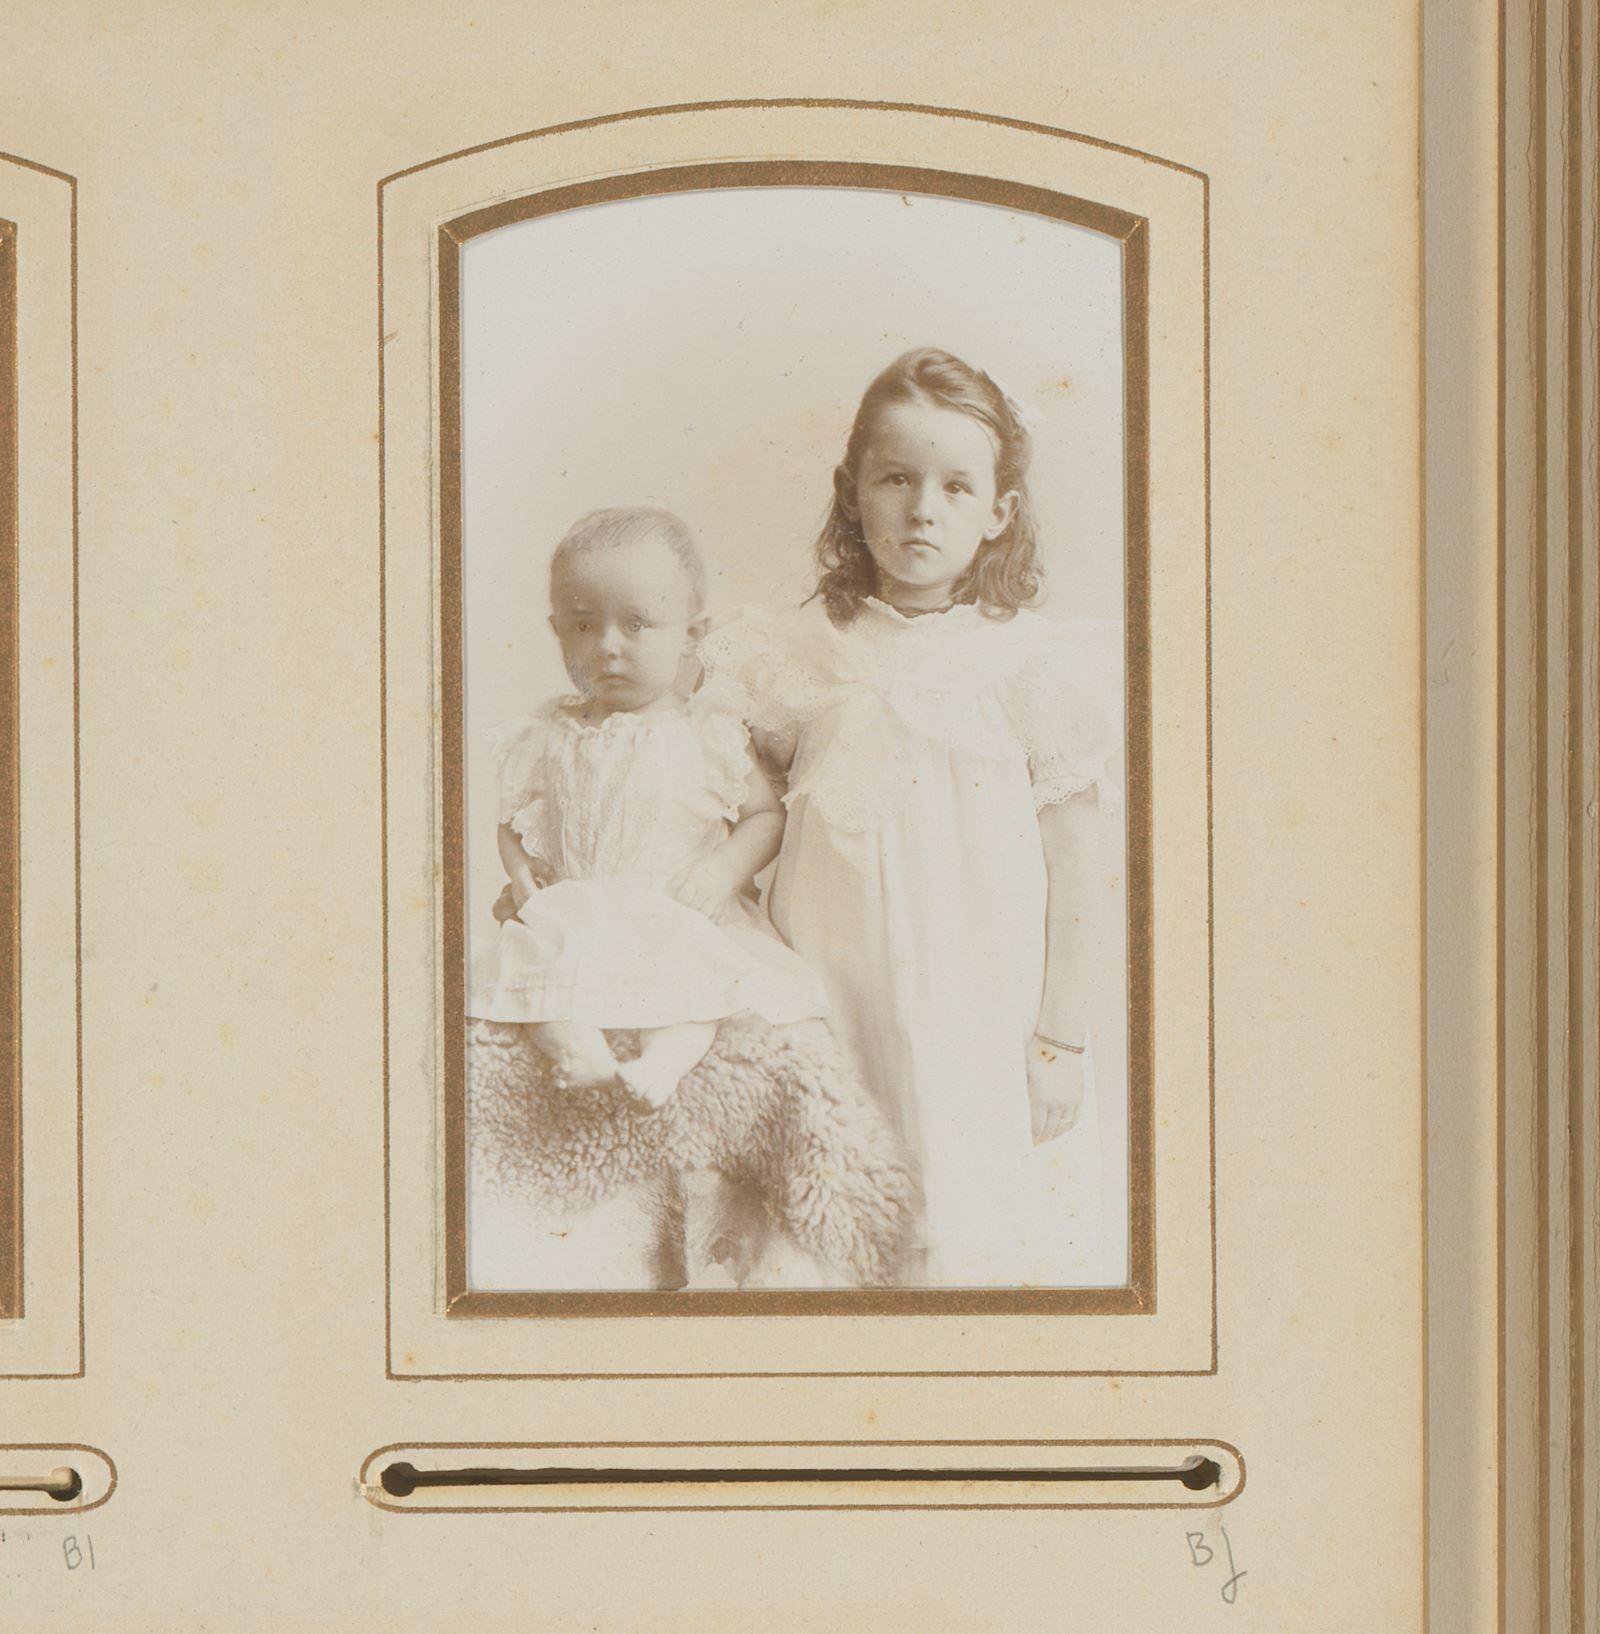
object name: photograph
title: Portret van een zittende baby en een staand meisje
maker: lambertus van der feer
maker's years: 1867-1920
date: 1895-1918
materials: cardboard, photographic support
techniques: collodion silver print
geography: sneek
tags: historical persons - bb - woman, girl (child between toddler and youth), infant, baby ~ the ages of man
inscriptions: inscription: ‘Photographisch/ Atelier/ van/ L. van der Feer Pzn/ Botnia Kade 60/ Nieuwe Kade/ Sneek/ Inrichting voor Vergrootingen./ De plaats blijft voor Nabestelling bewaard.’